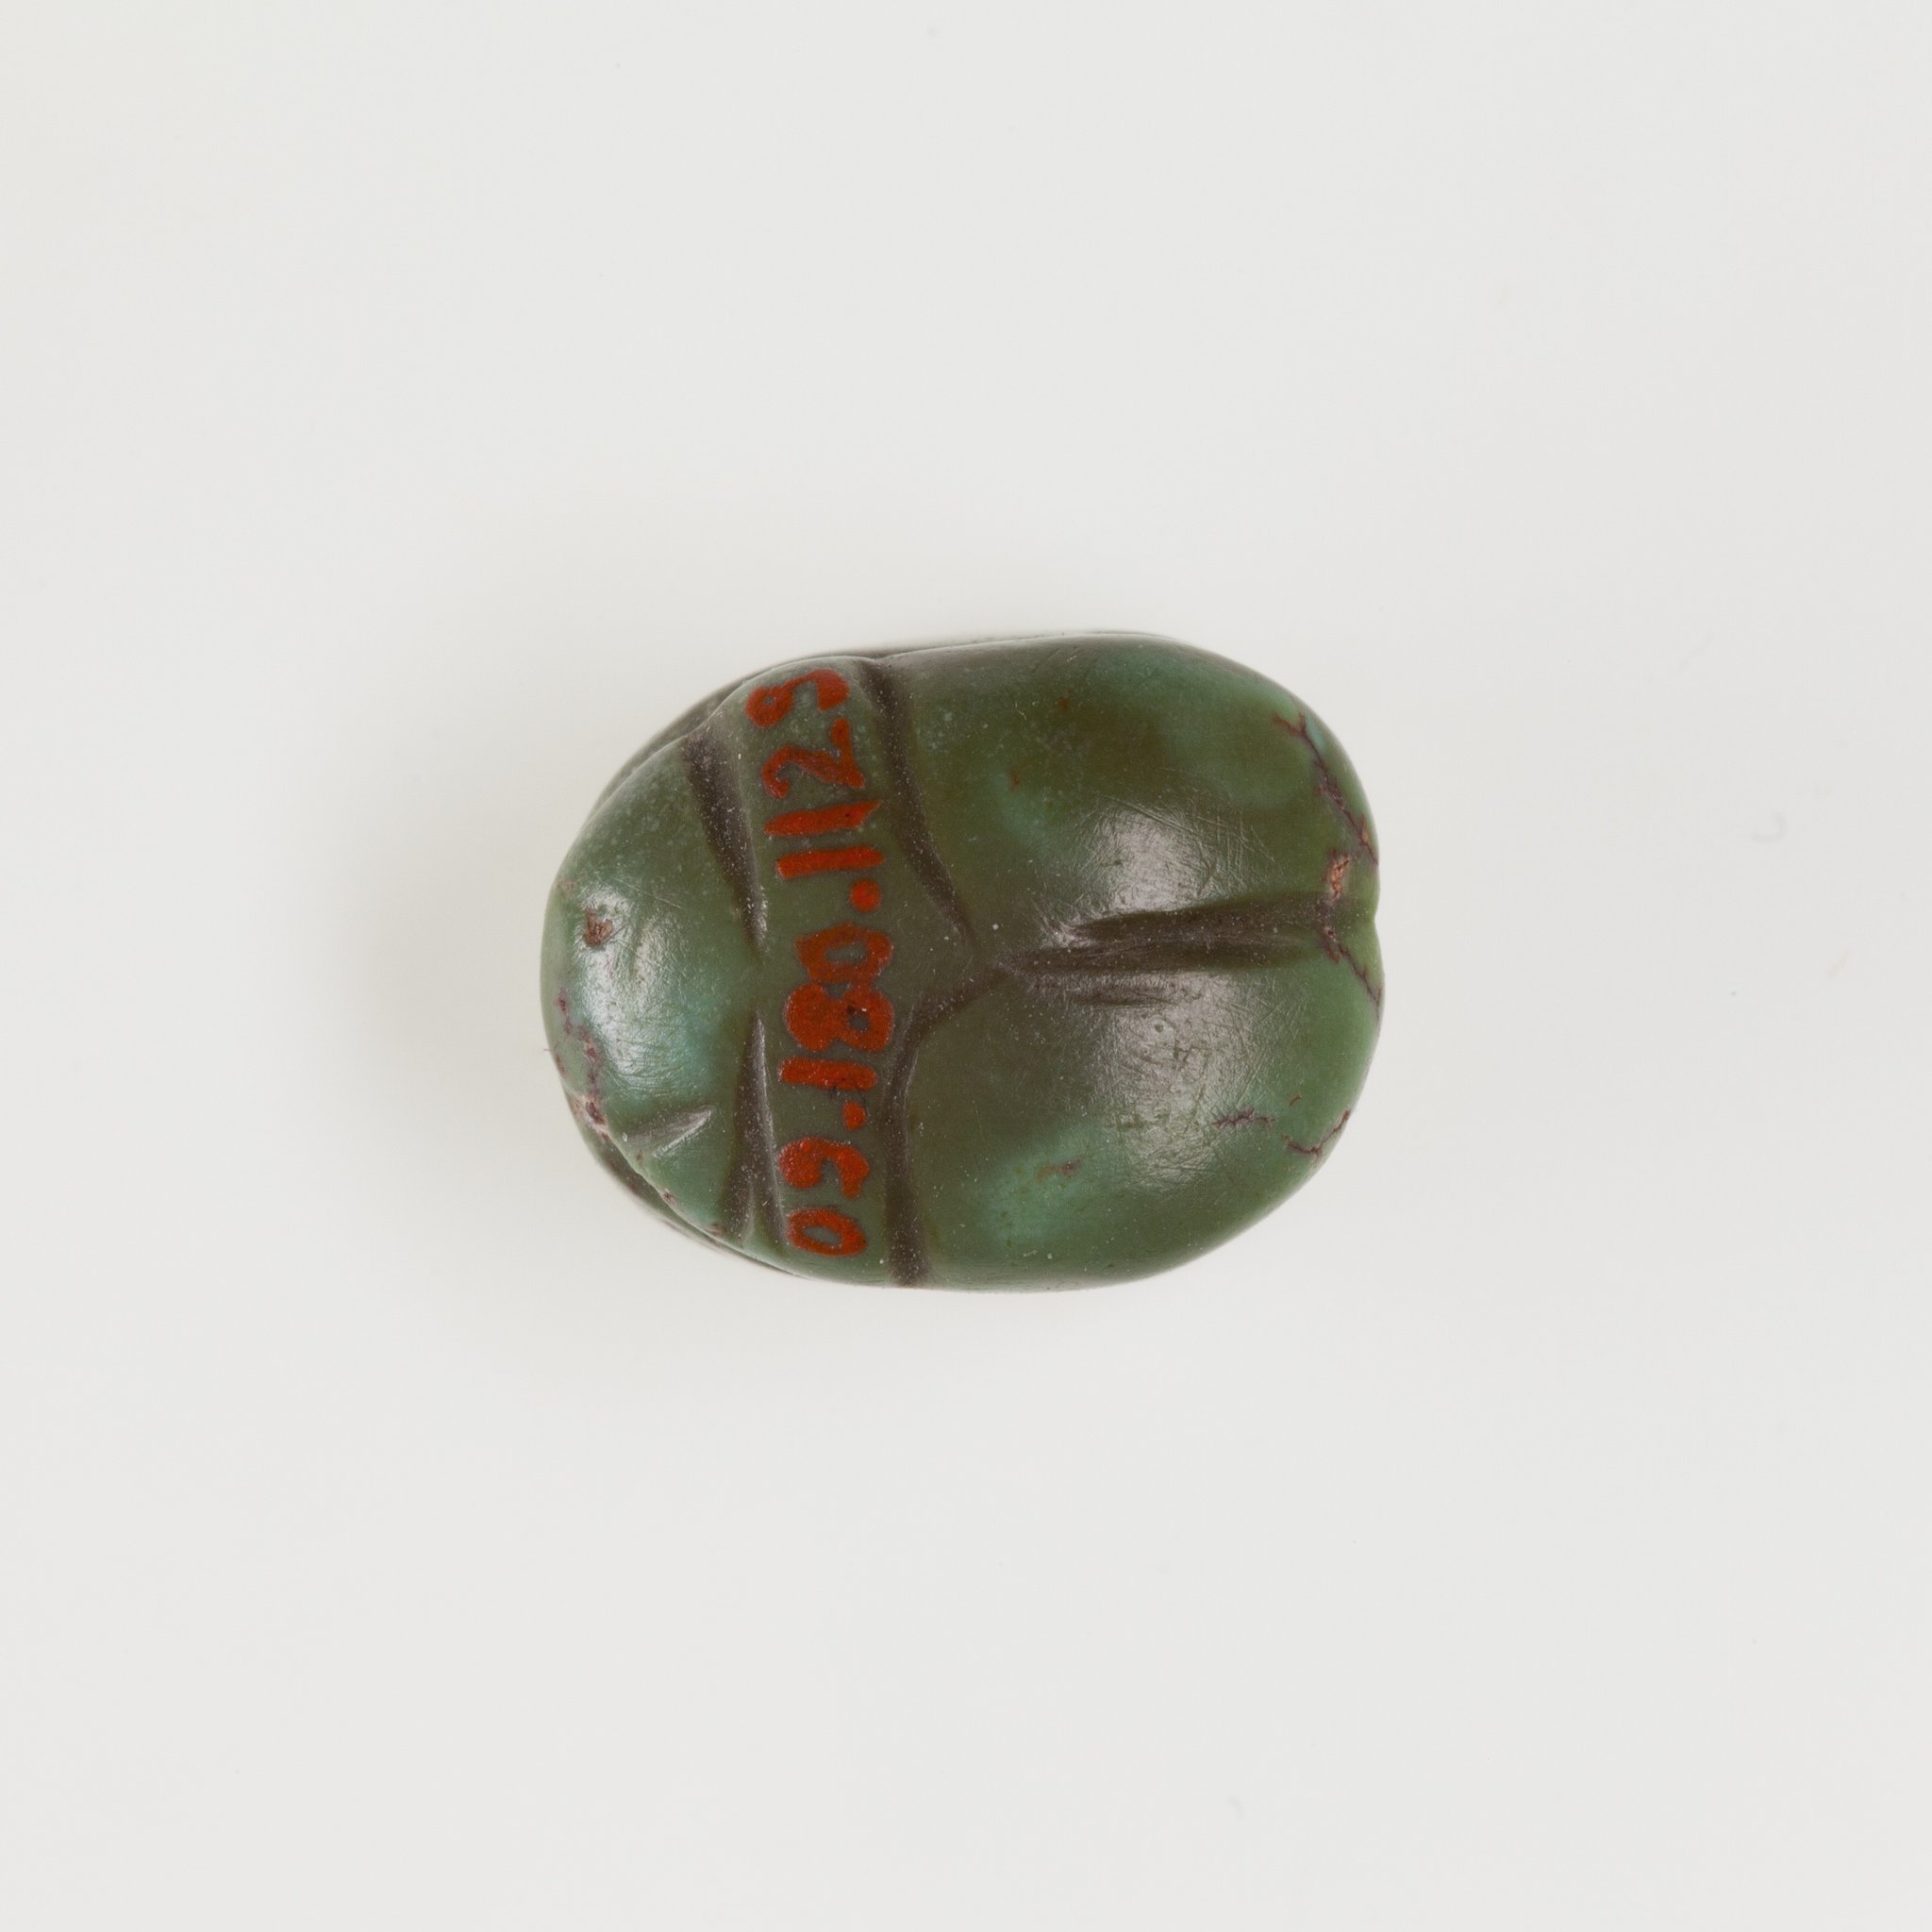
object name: scarab, uninscribed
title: Scarab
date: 1981-1550 BCE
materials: jasper, stone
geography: egypt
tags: scarabs